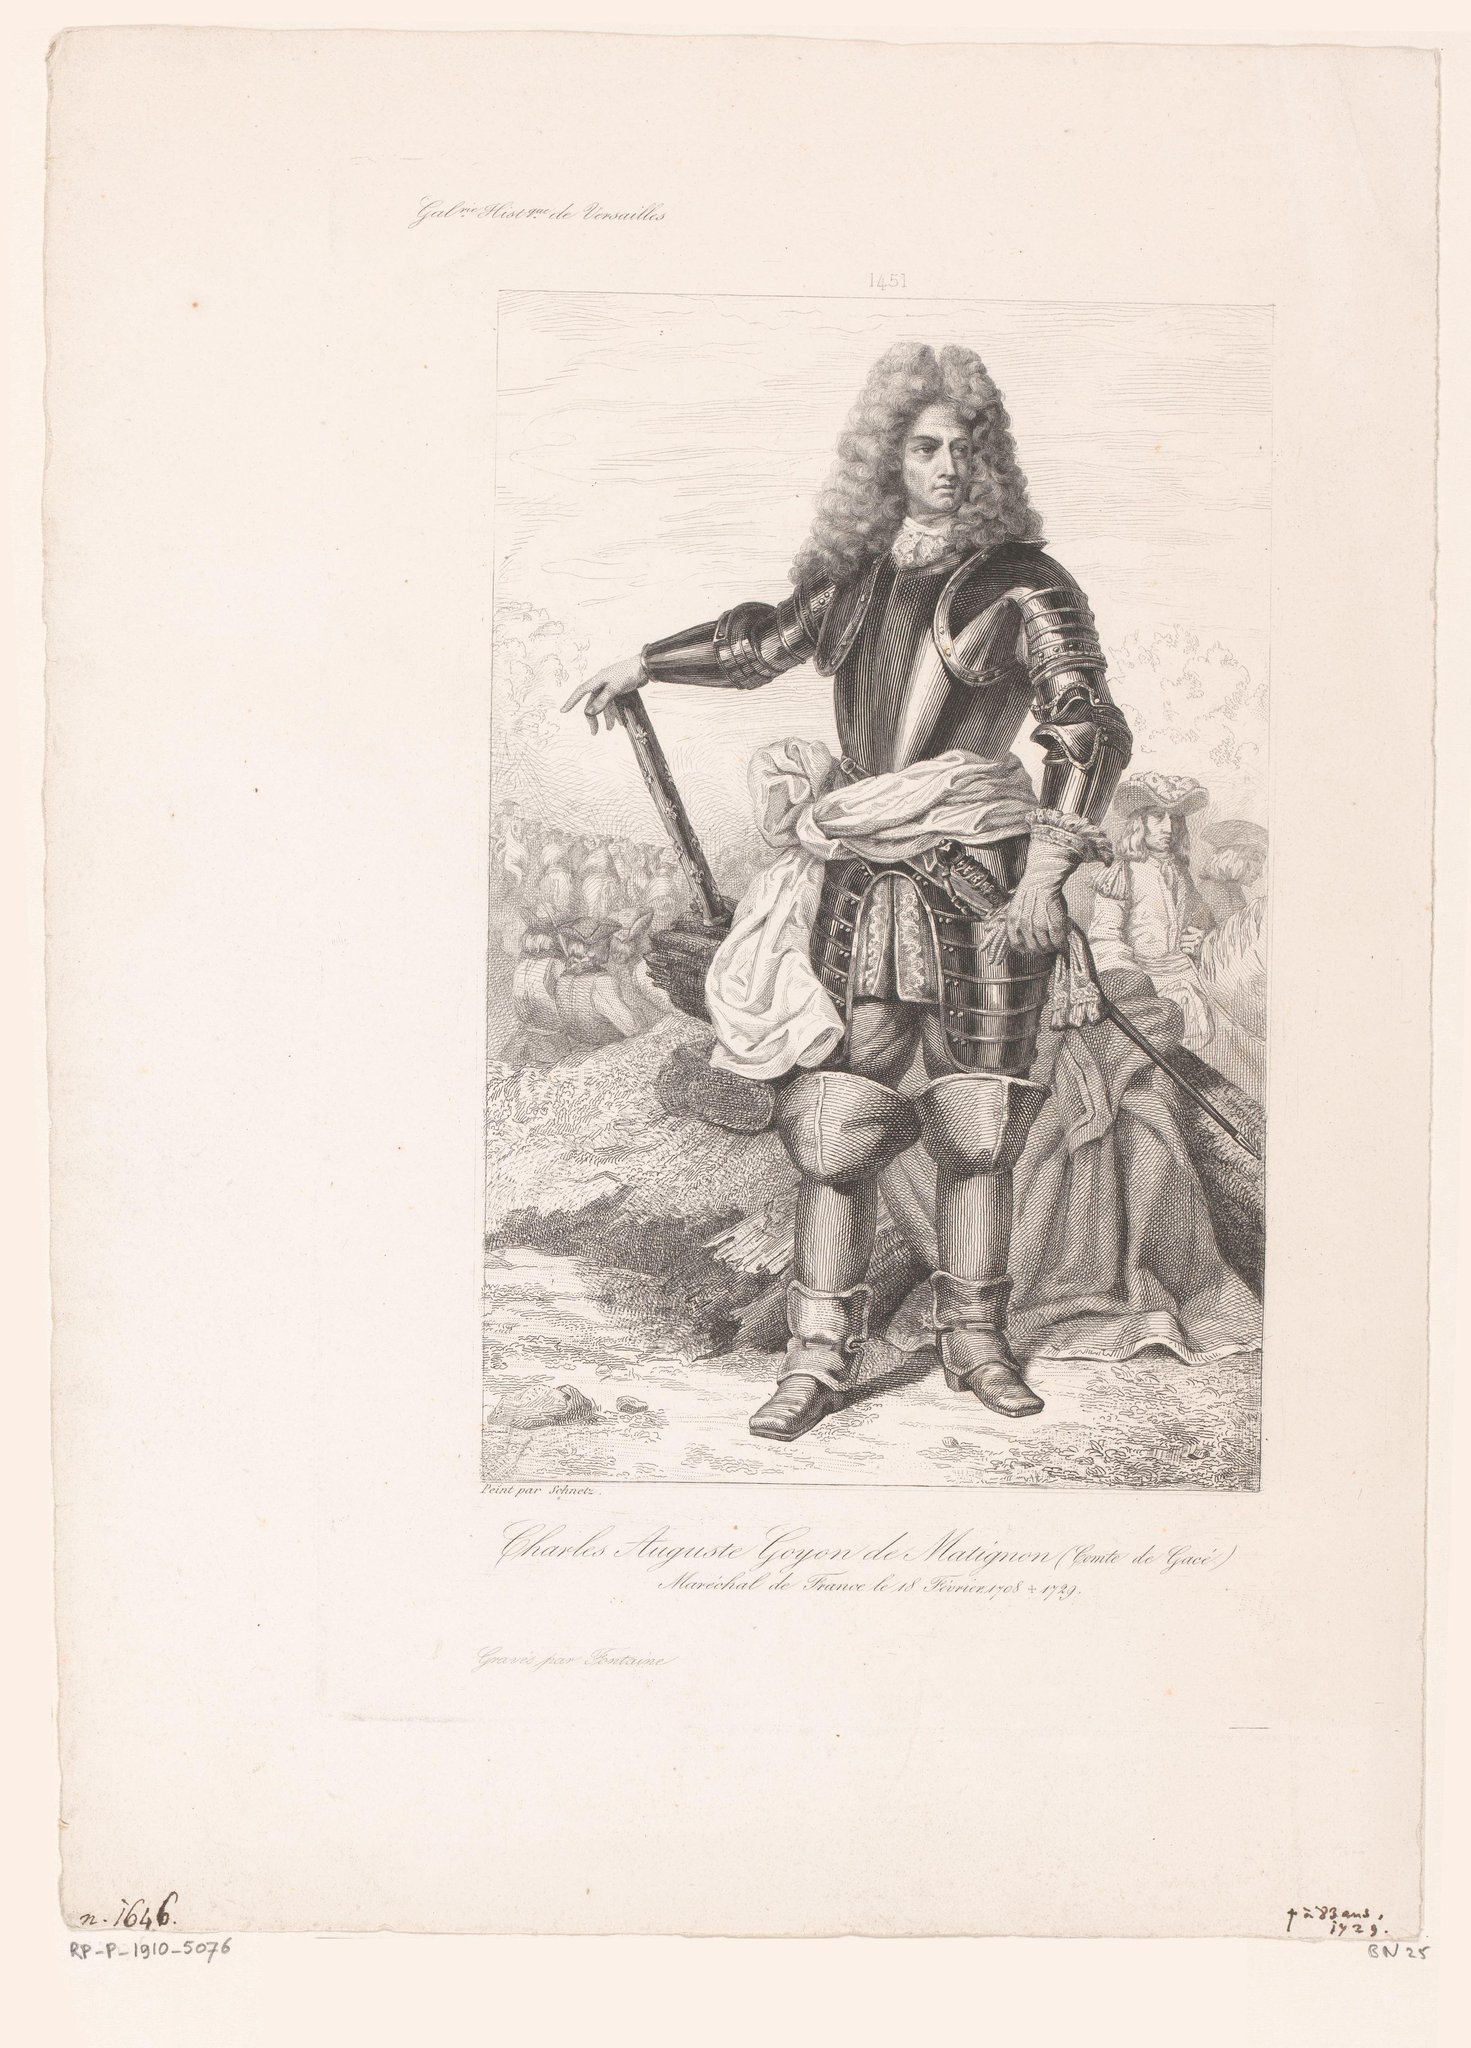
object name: print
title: Portret van Charles Auguste de Goyon de Matignon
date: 1838-1841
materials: paper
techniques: engraving, etching, roulette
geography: france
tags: paris, commander-in-chief, general, marshal, historical persons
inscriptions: collector's mark: Lugt 2228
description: Prent uit: s.n. Galeries historiques de Versailles. Parijs: Charles Gavard, 1838-1841.